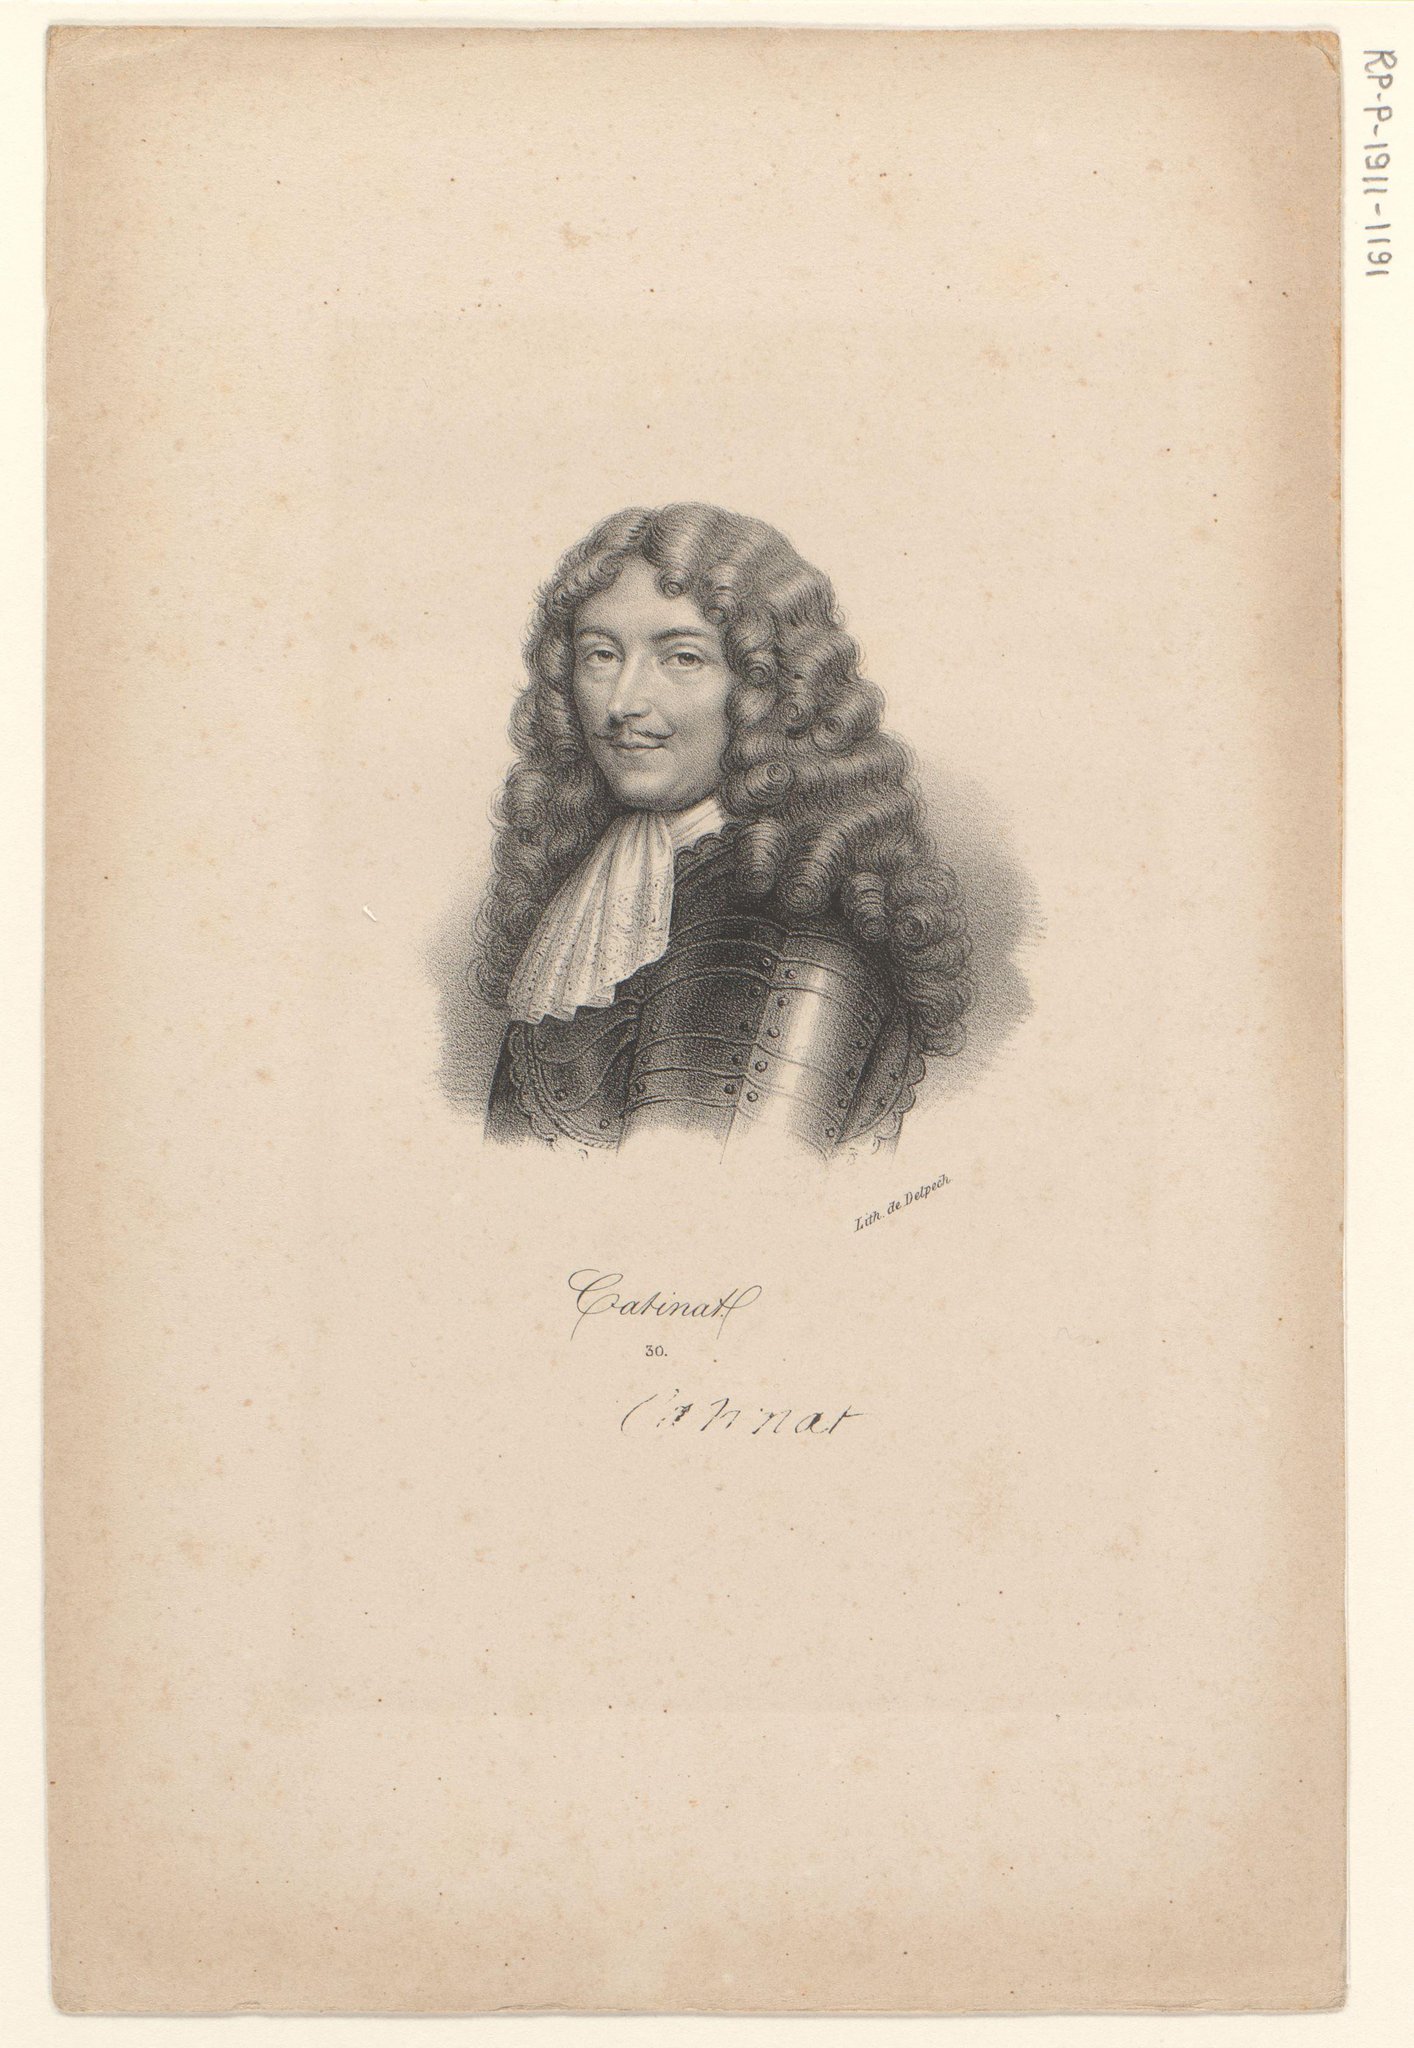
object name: print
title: Portret van Nicolas Catinat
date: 1818-1842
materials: paper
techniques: lithograph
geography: paris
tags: historical persons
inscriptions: collector's mark: Lugt 2228a